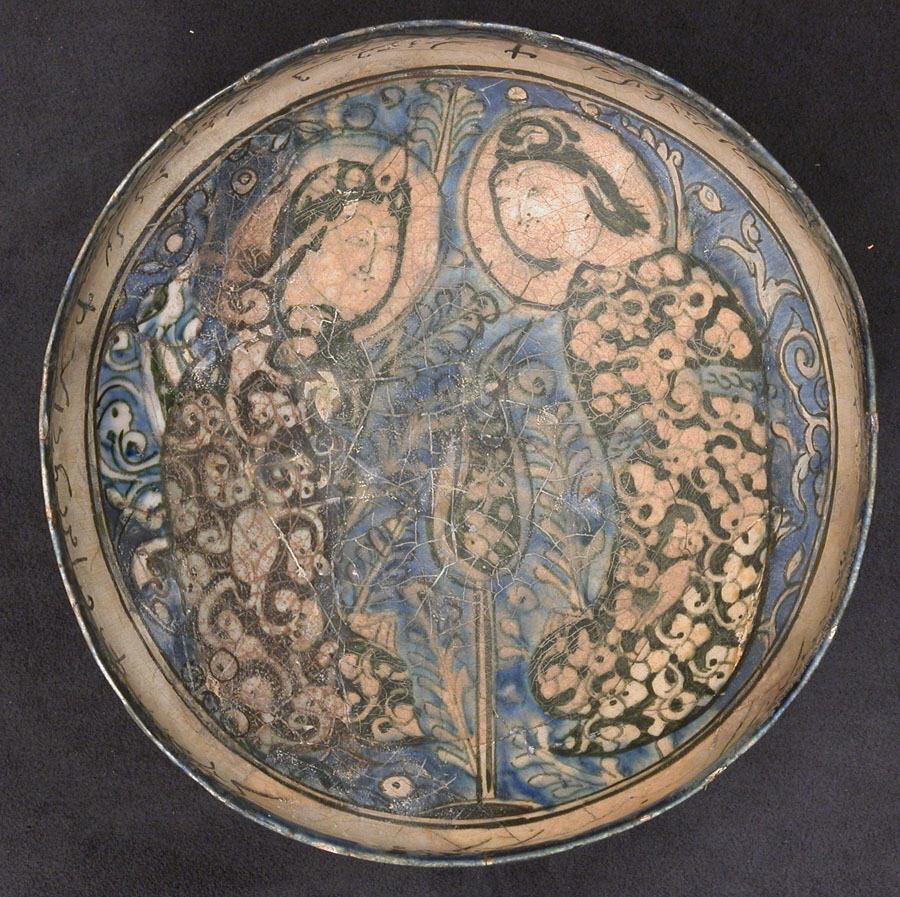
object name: bowl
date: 1167-1233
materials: glaze, stonepaste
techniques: painting, polychrome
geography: iran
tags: human figures